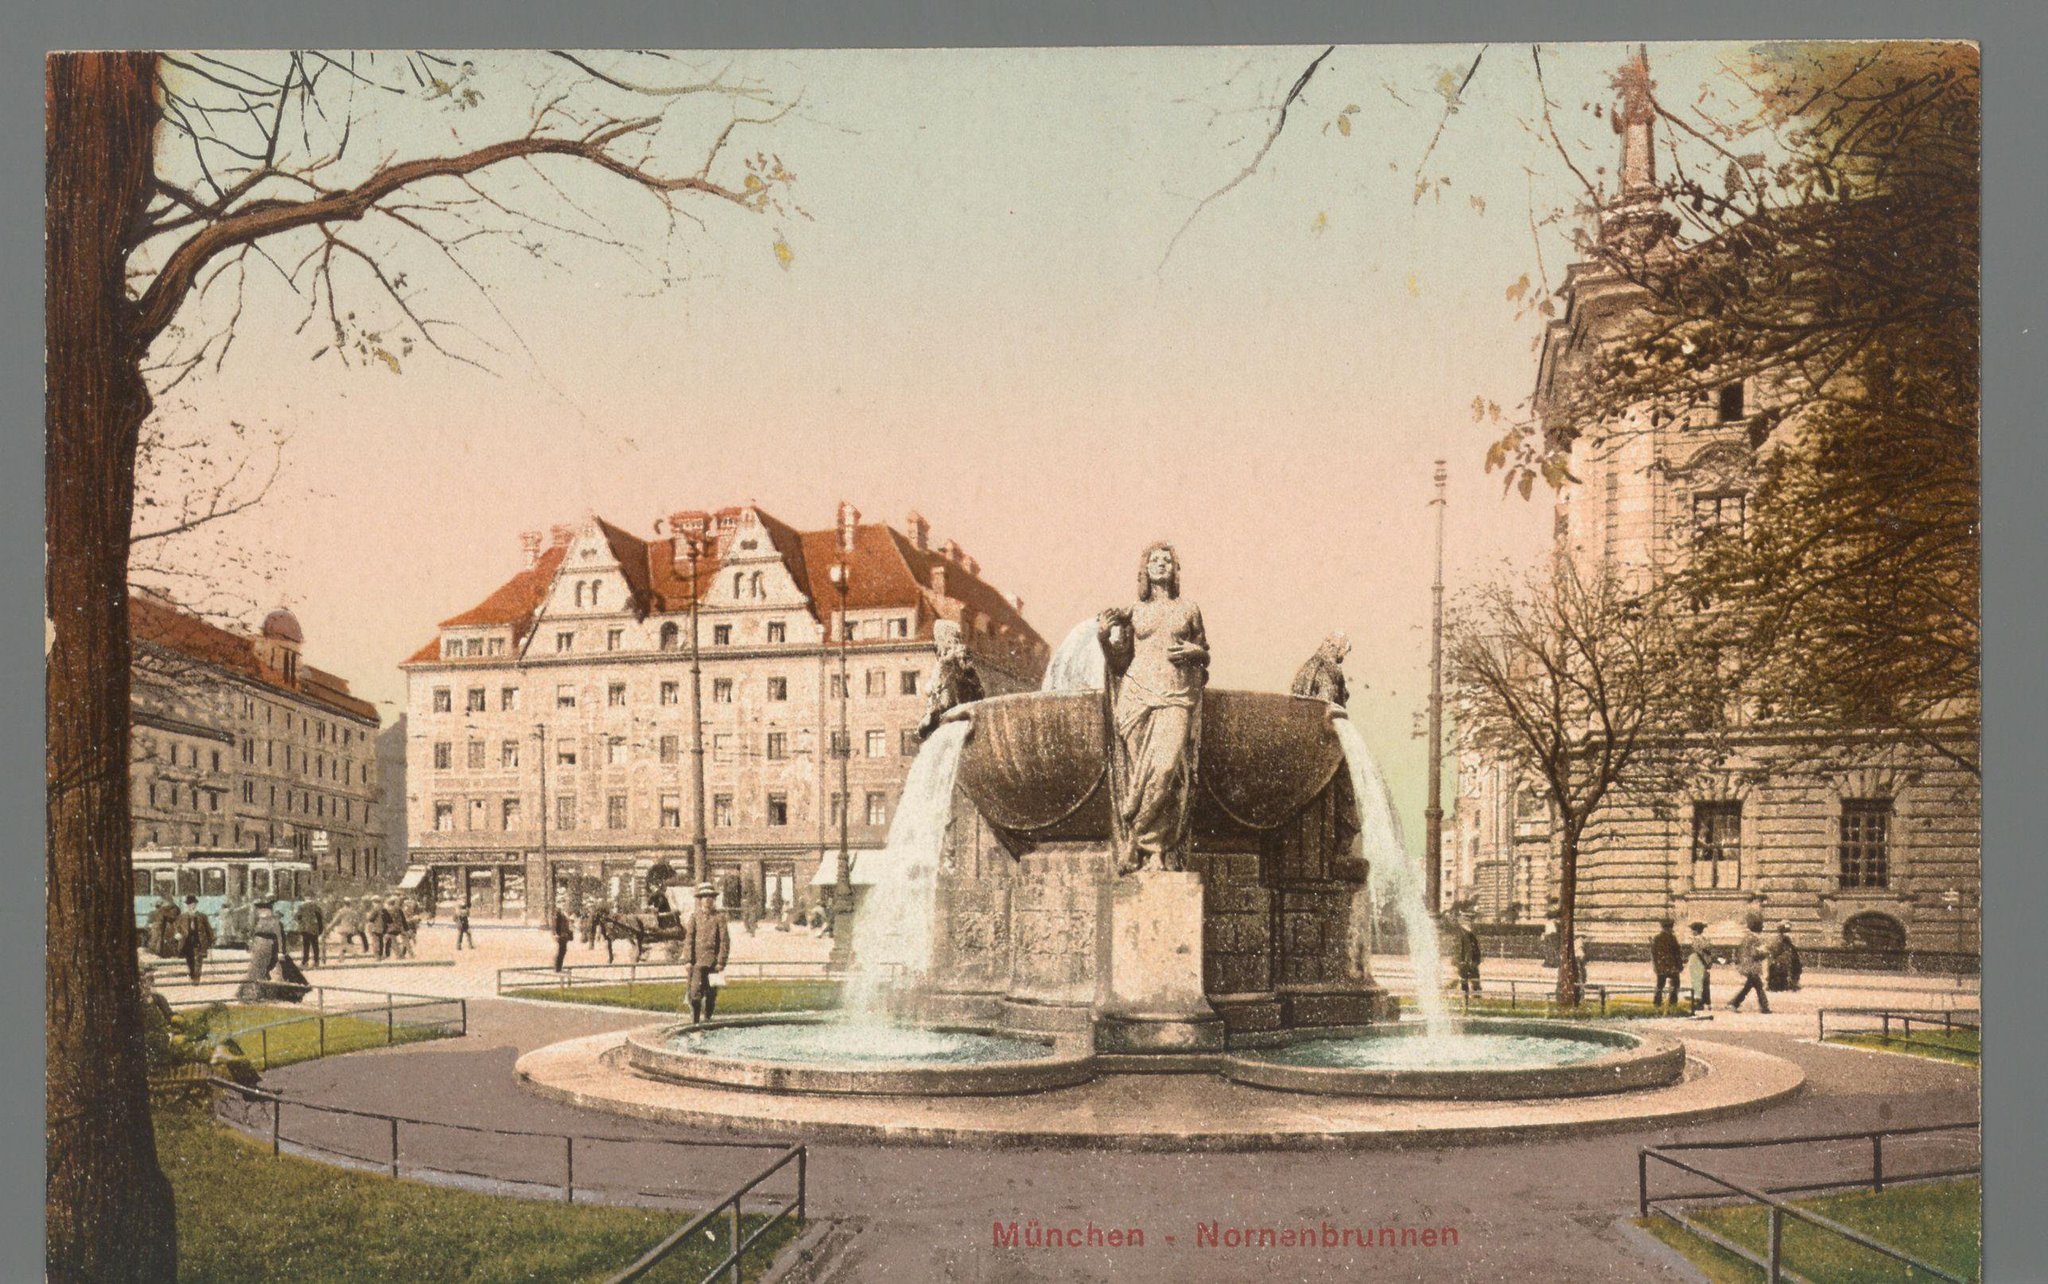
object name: ansichtkaart, prentbriefkaart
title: München - Nornenbrunnen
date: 1907-1909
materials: cardboard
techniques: lithograph, writing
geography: munich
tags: ornamental fountain